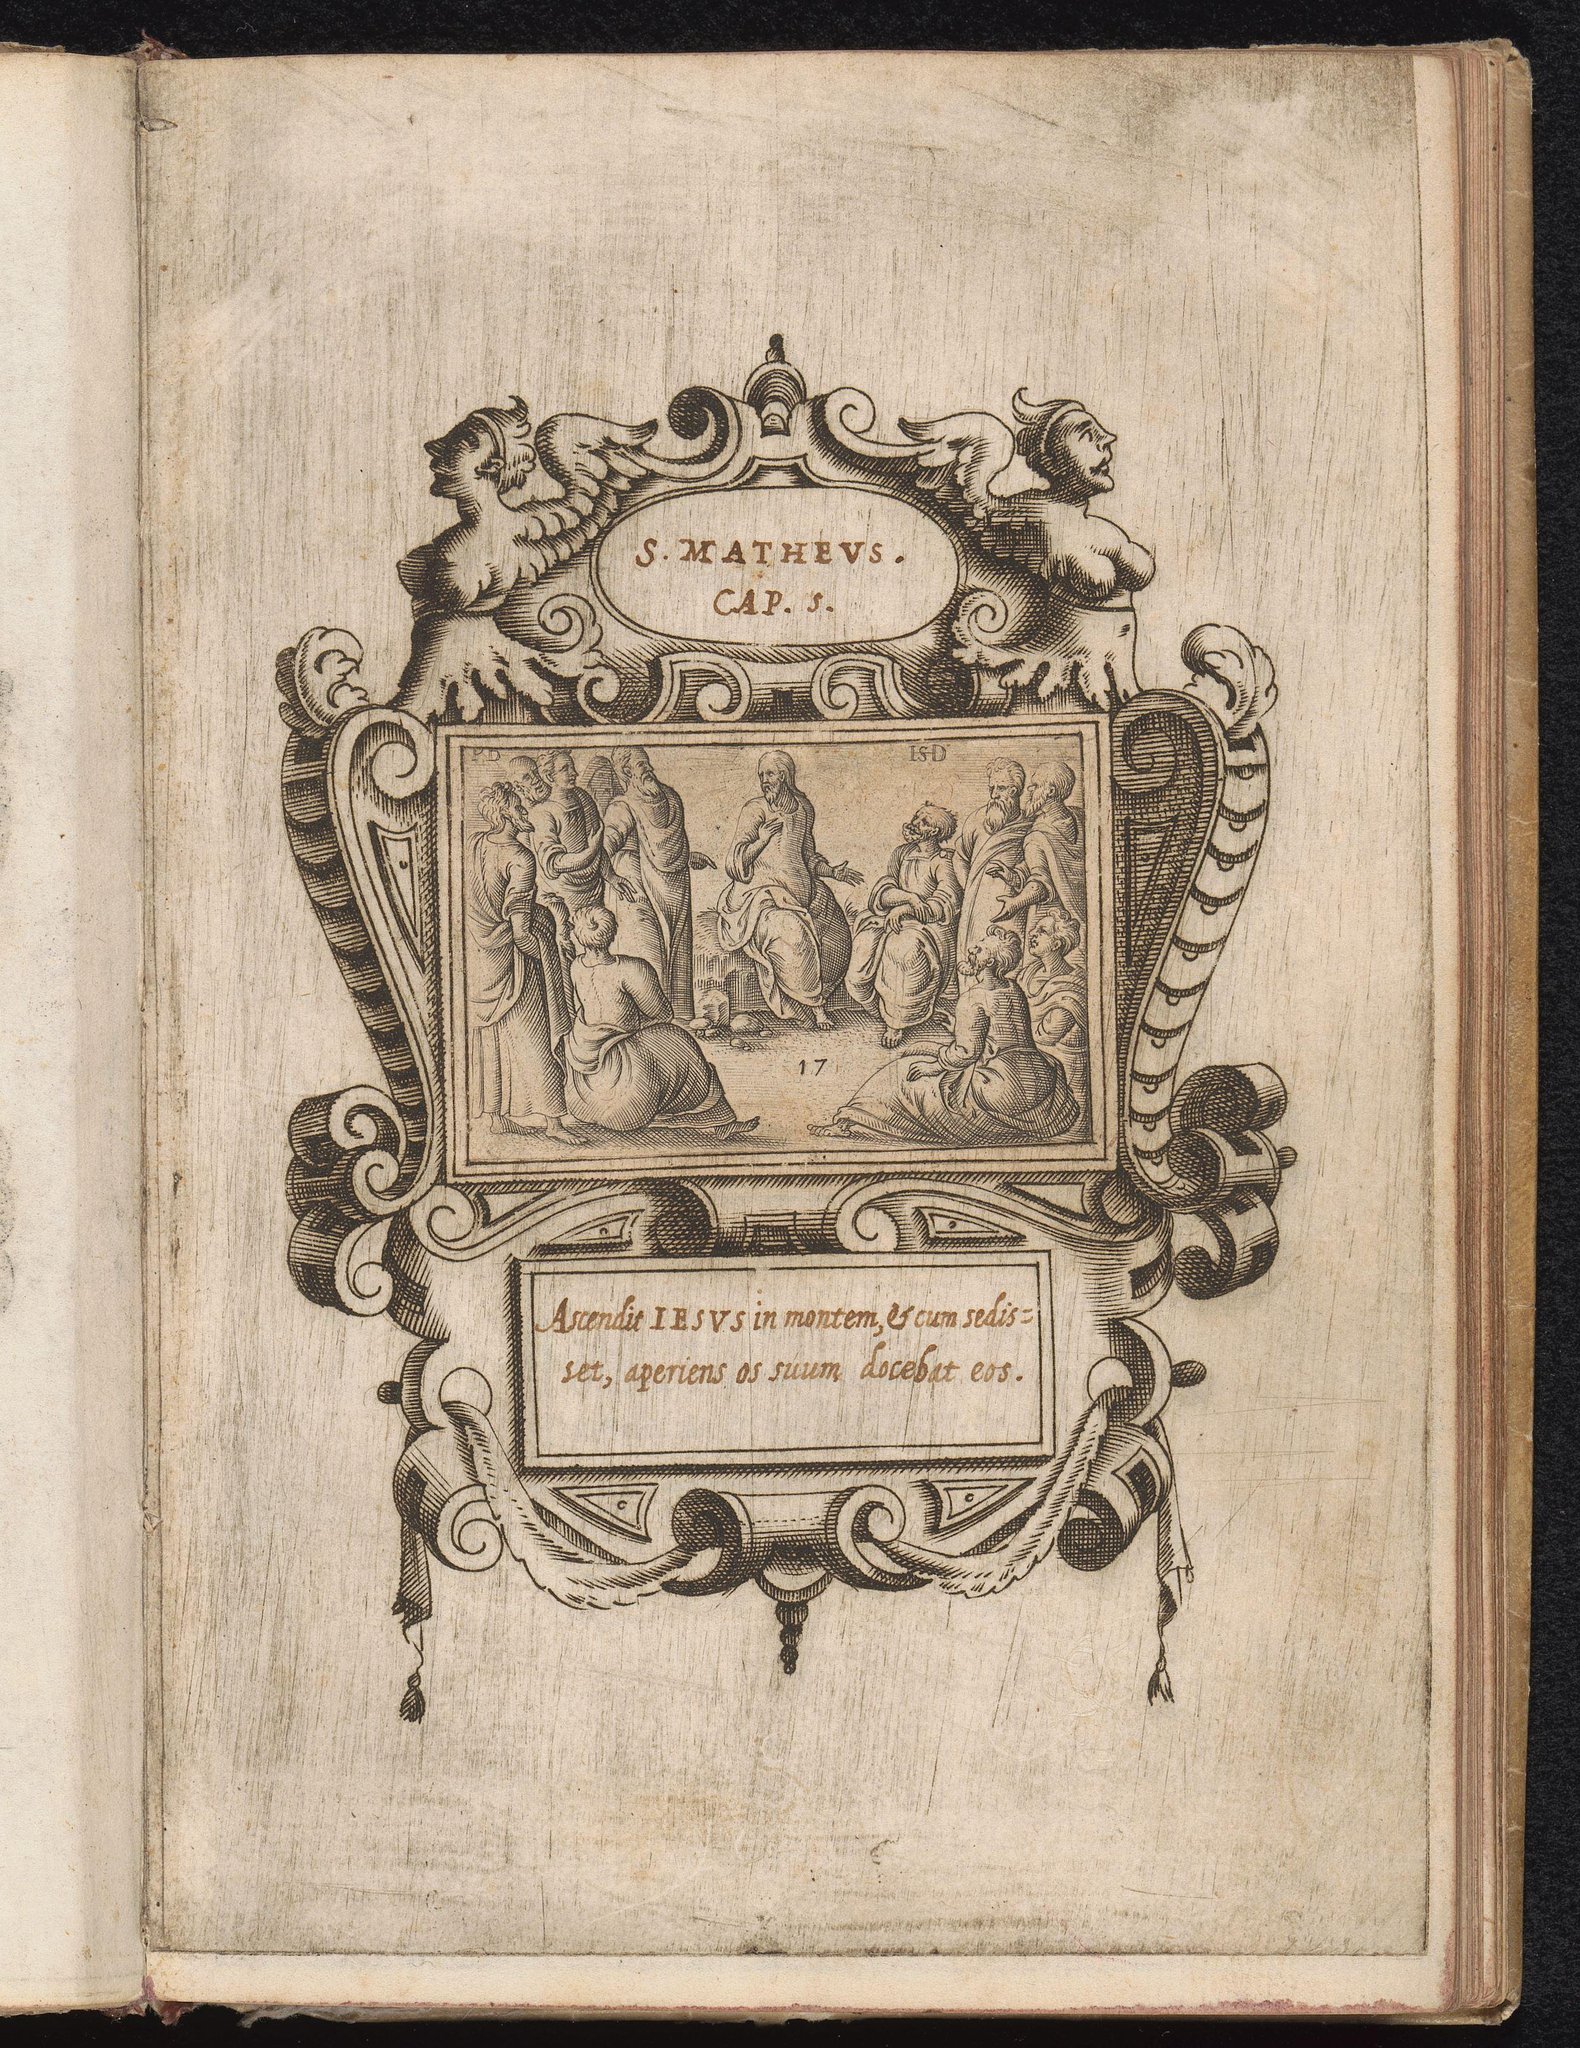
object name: print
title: Het leven van Christus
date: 1570-1610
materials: paper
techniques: engraving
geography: antwerp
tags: christ's sermon on the mount (matthew 5-7)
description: Christus predikt op de berg. Onderdeel van een prentalbum met titelprent en 56 scènes uit het Nieuwe Testament. Elke voorstelling gemonteerd in een gravure met ornamentele cartouches waarin een venster is gesneden en voorzien van handgeschreven bijbelpassages.